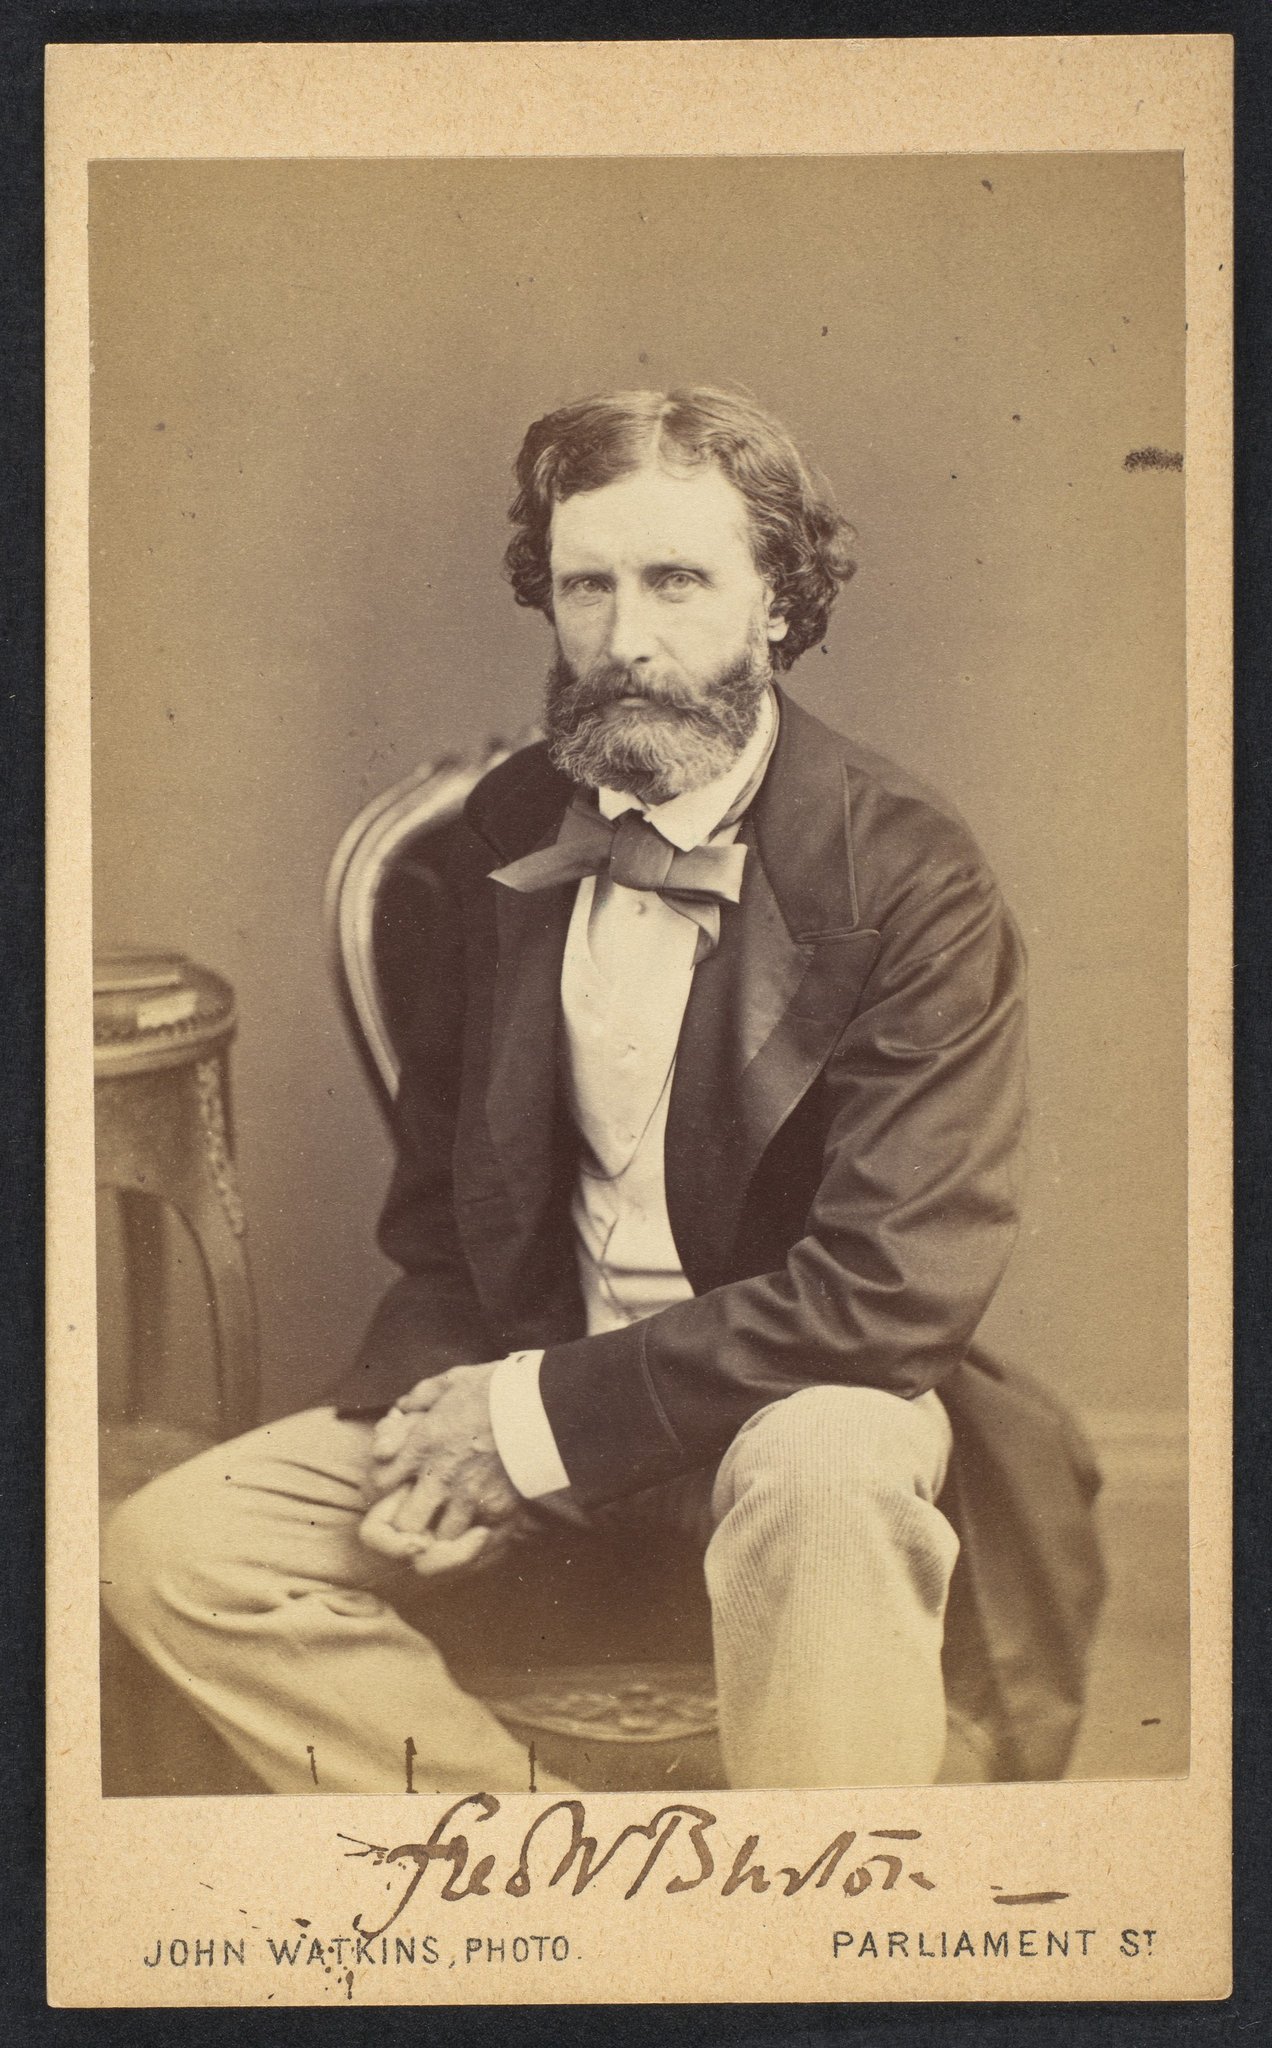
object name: carte de visite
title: [Frederic William Burton]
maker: john and charles watkins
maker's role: photography studio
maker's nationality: british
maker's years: 1840-1875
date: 1860-1869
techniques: albumen silver print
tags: men,portraits